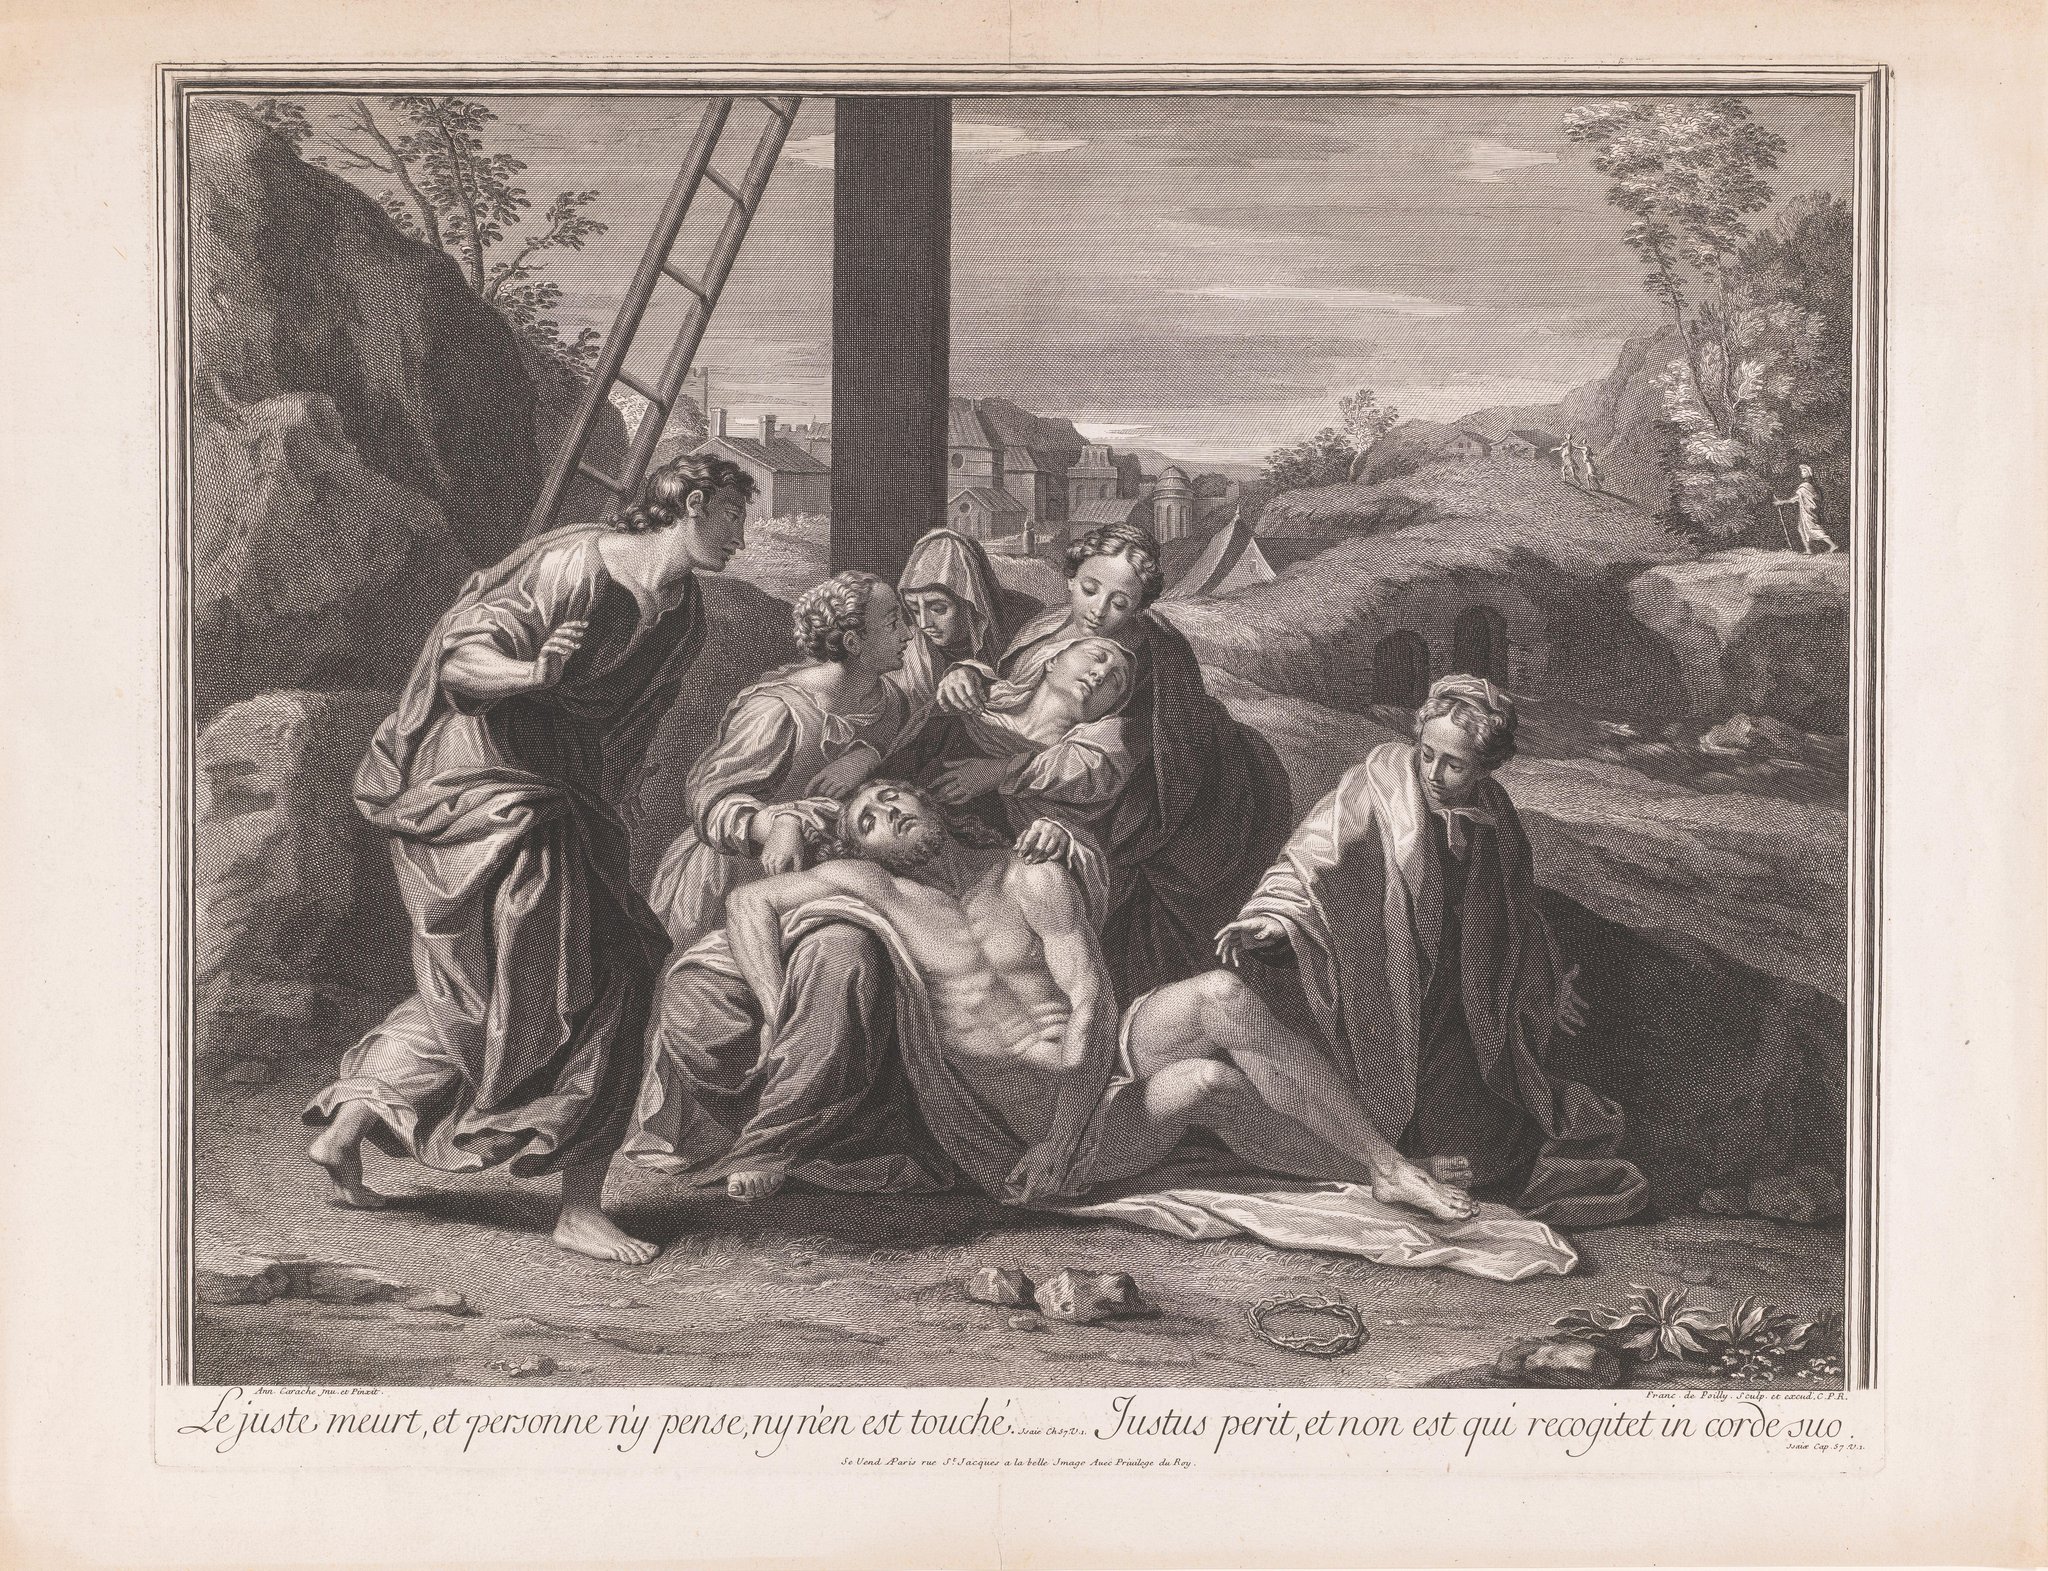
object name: print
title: Bewening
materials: paper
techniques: engraving, etching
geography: paris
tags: christ is laid down ~ descent from the cross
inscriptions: collector's mark: Lugt 240